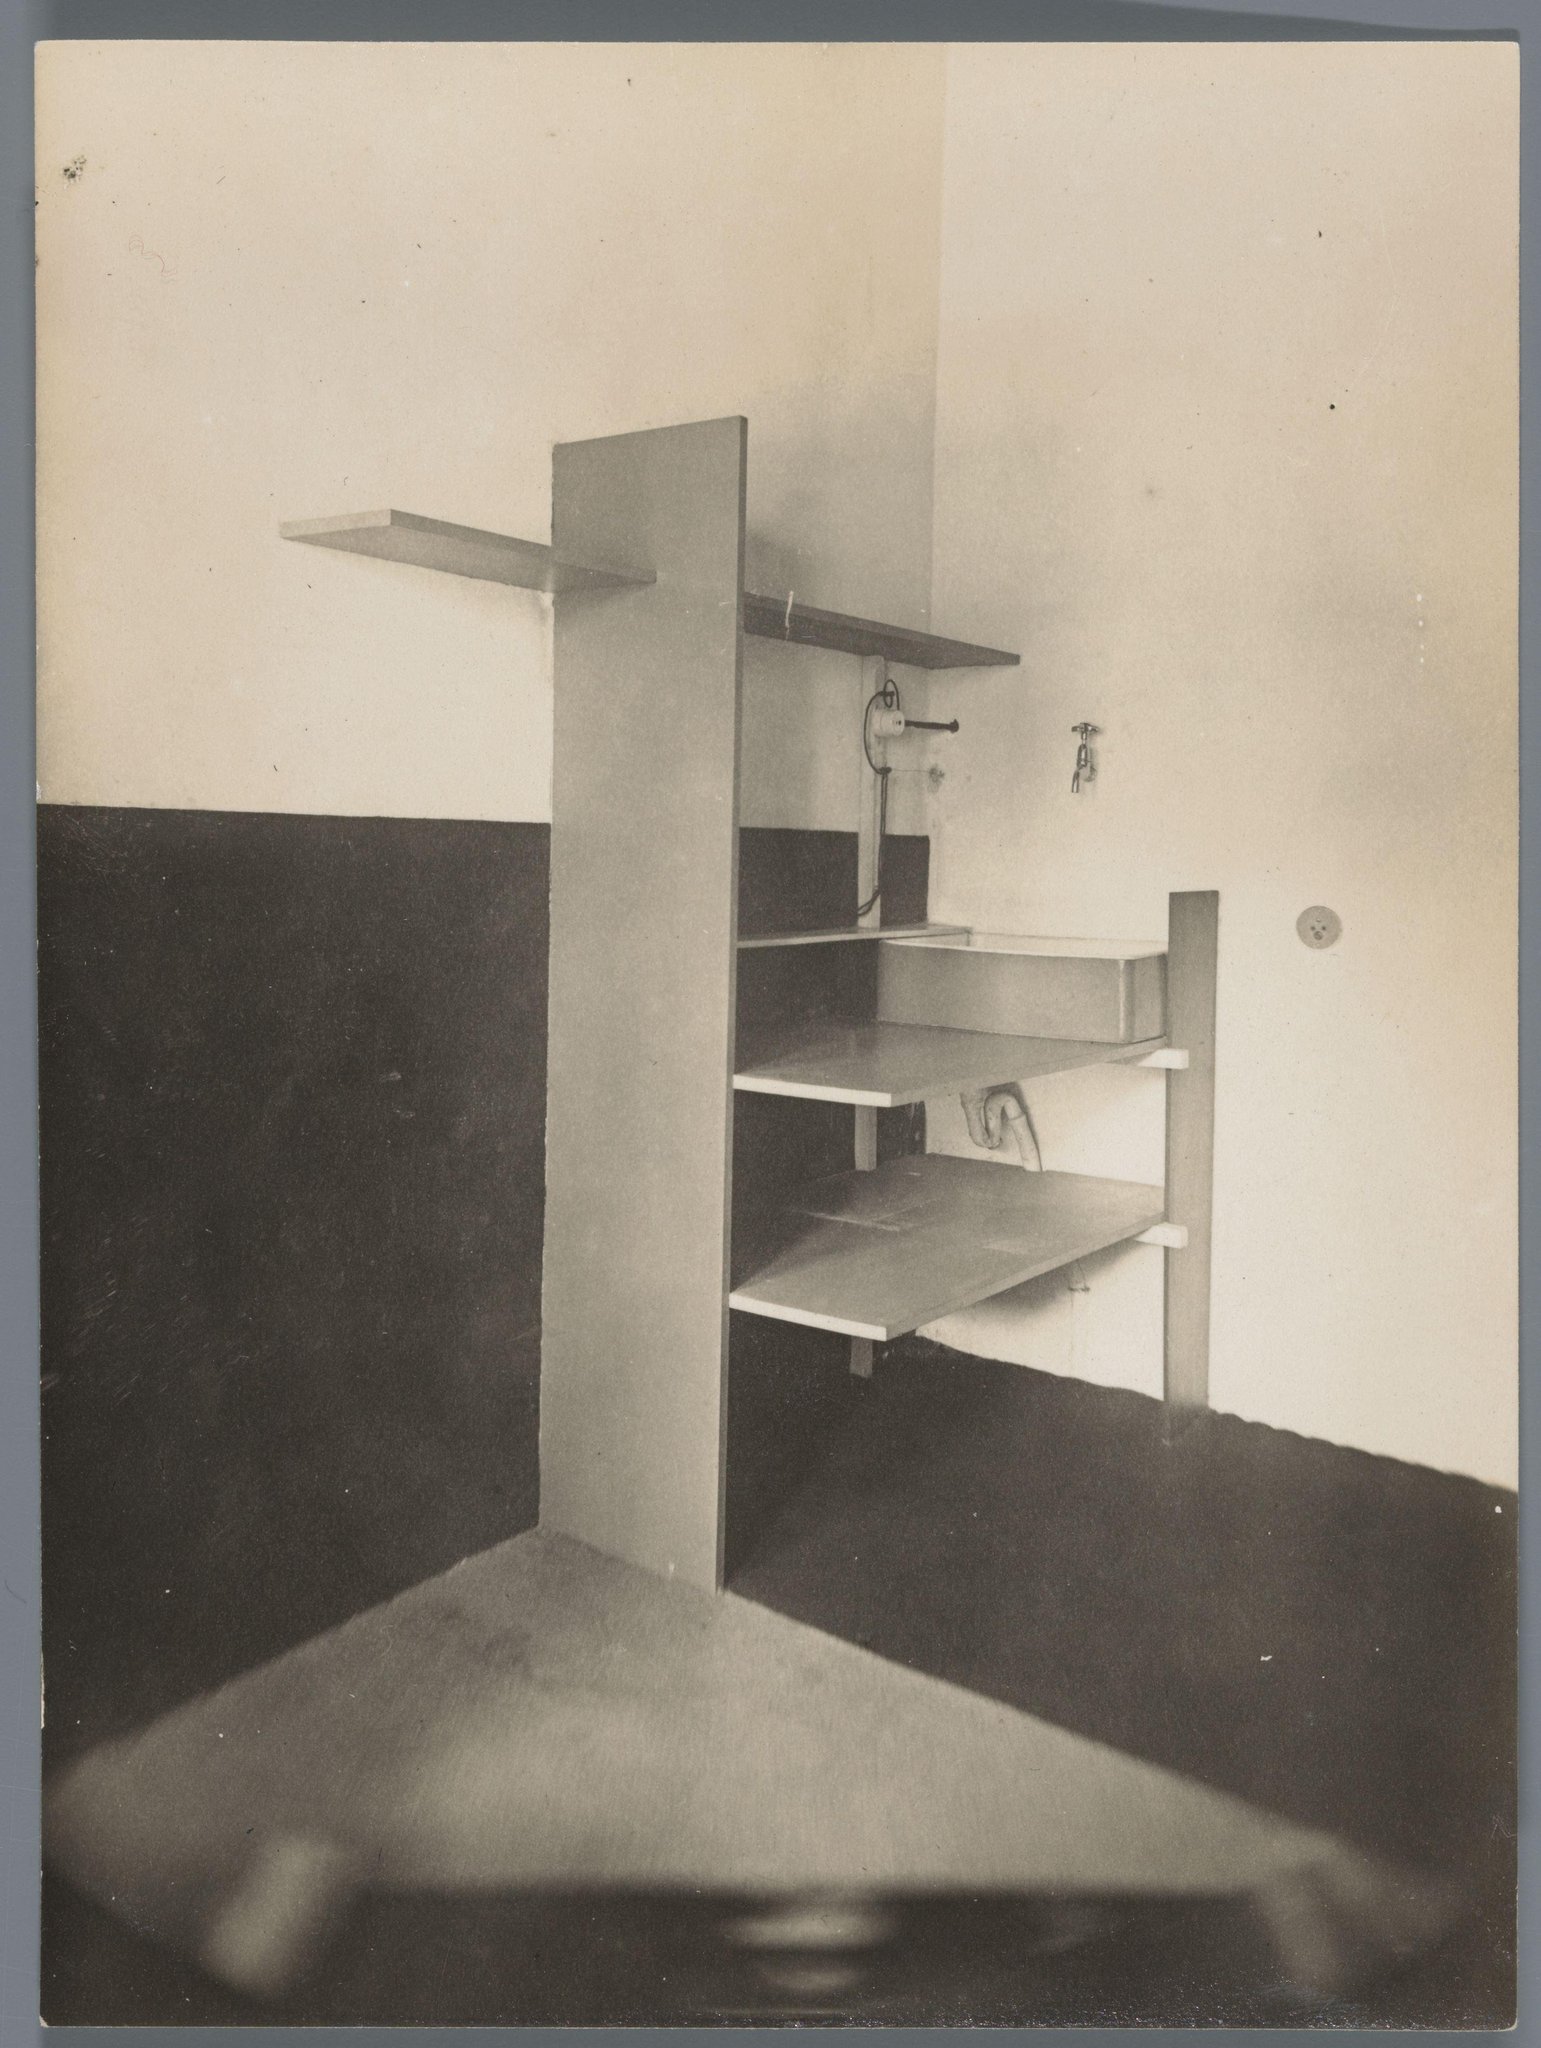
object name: photograph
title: Wastafel in het Rietveld Schröder Huis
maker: Anonymous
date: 1928-1935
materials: photographic support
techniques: gelatin silver print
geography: utrecht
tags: other rooms